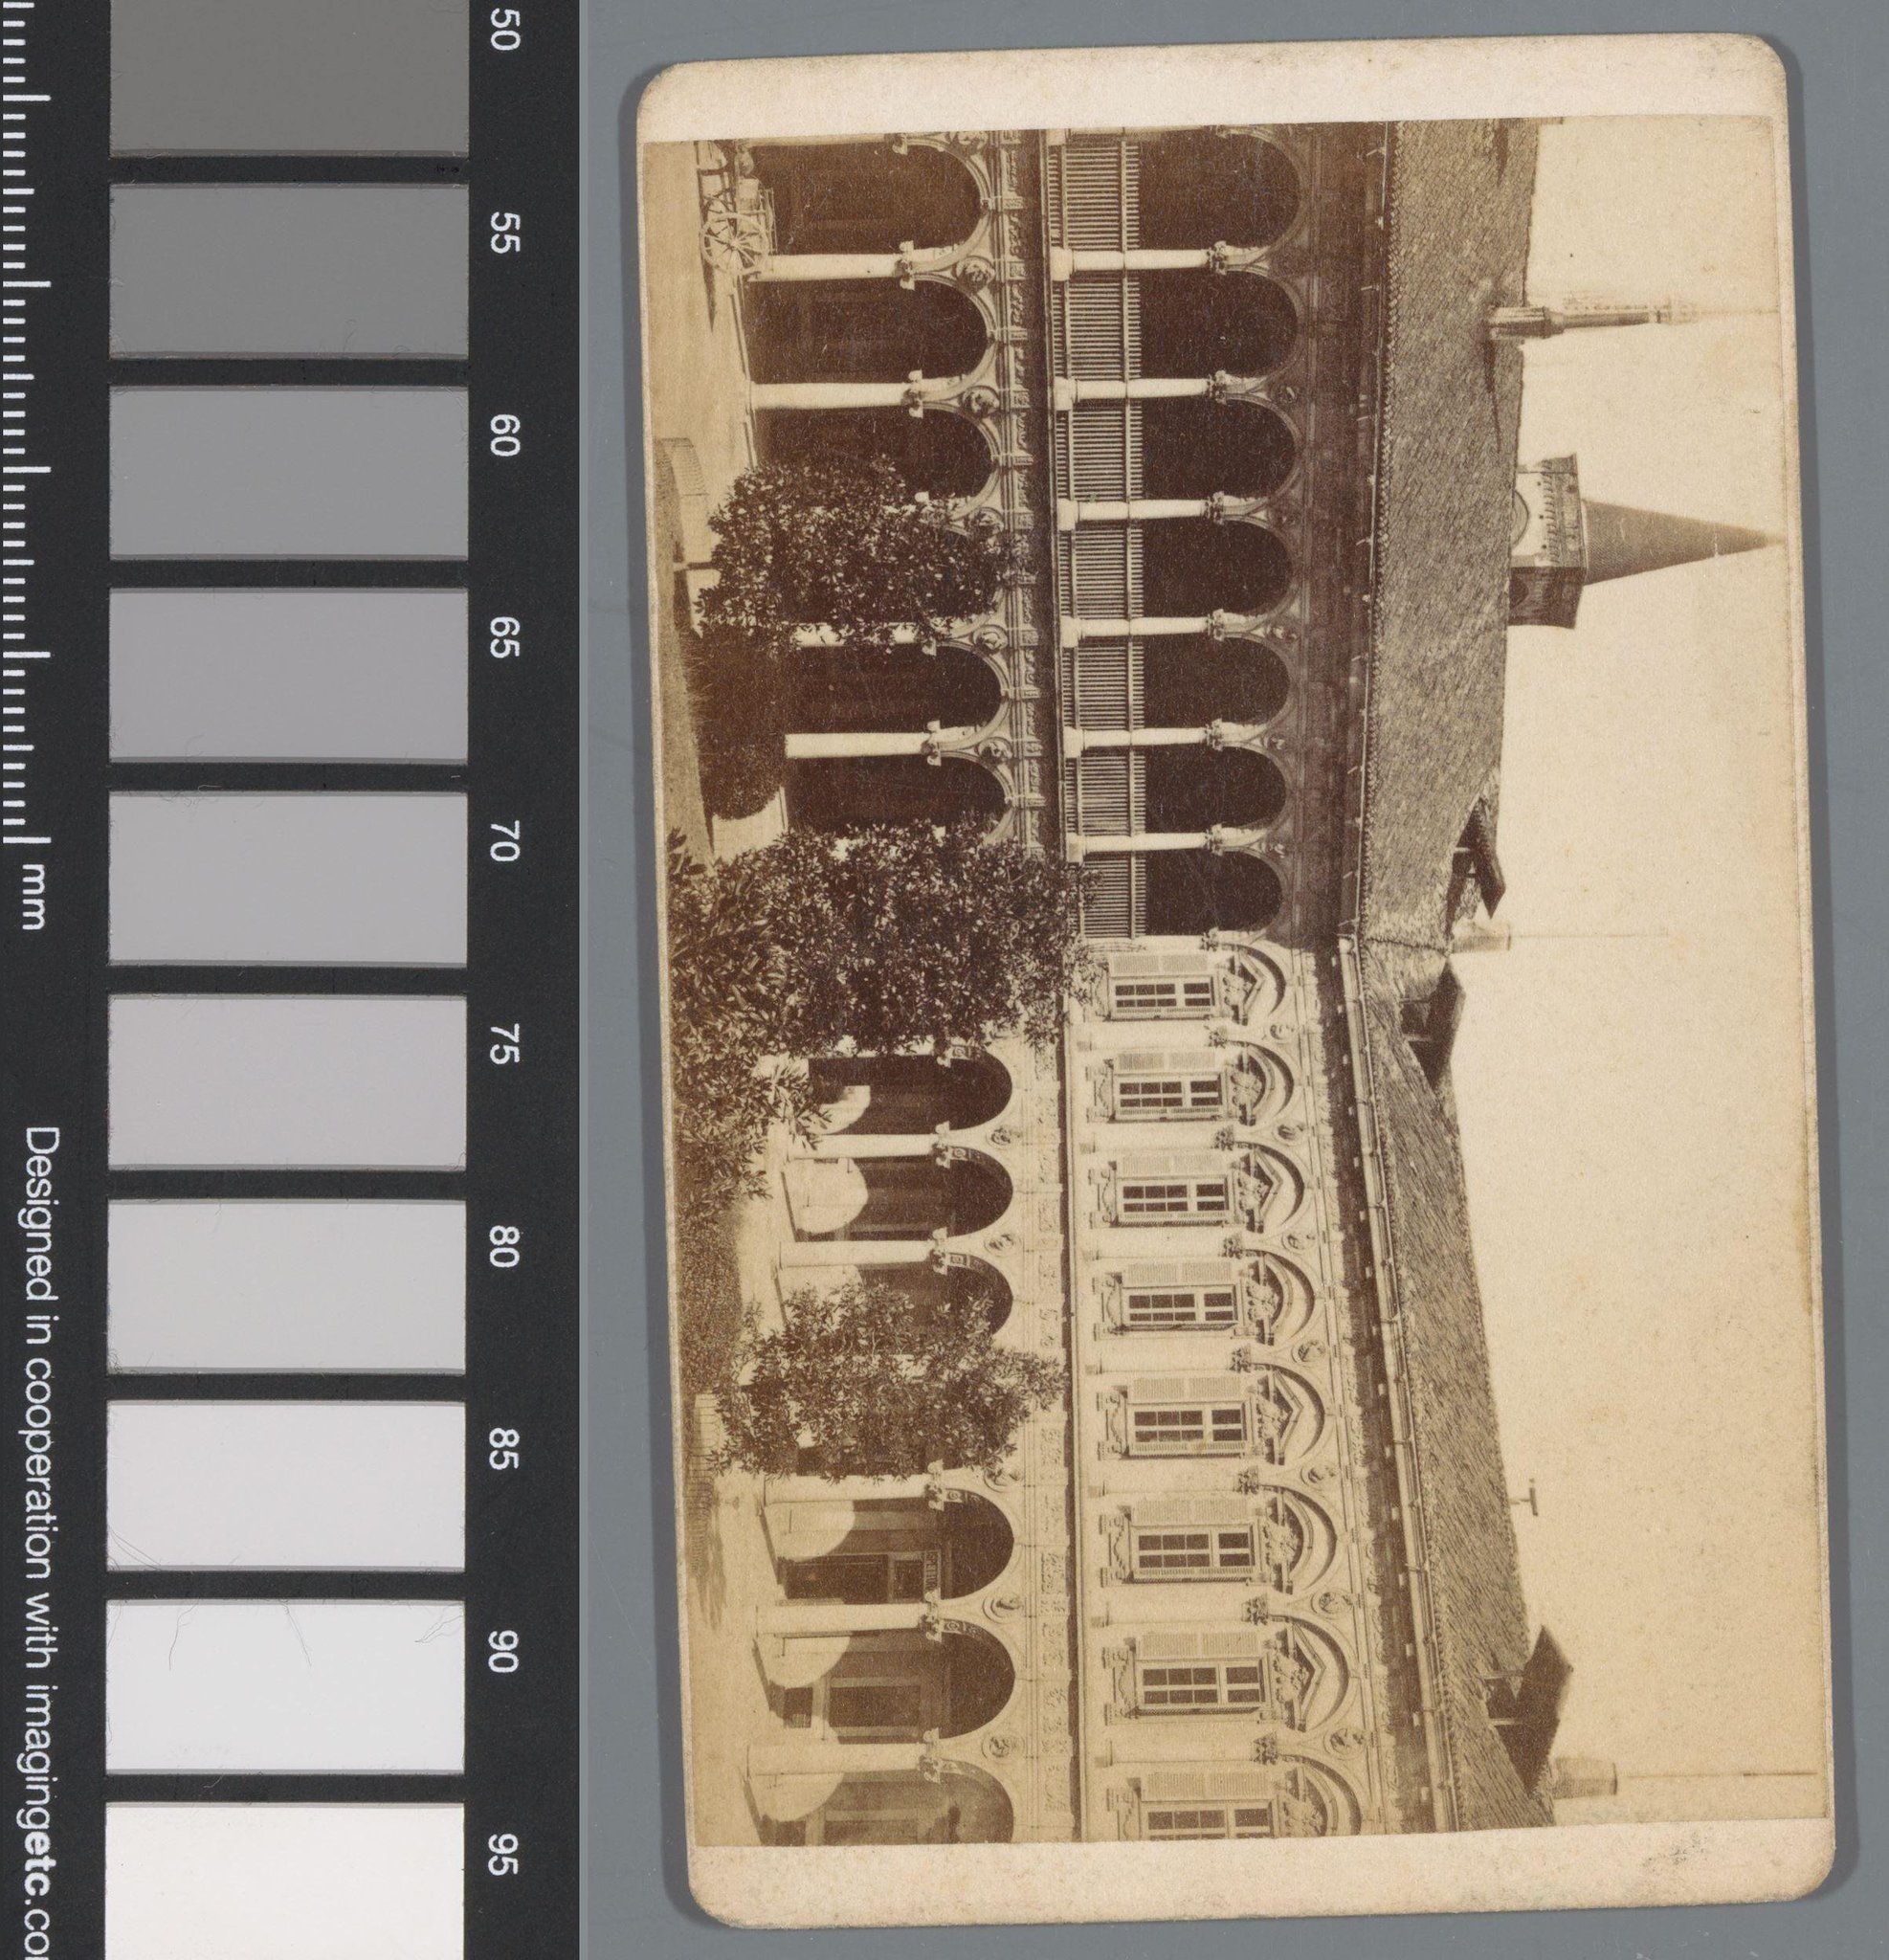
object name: photograph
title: Binnenplaats van het Antico Ospedale Maggiore, Milaan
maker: Anonymous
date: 1855-1885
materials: cardboard, paper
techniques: albumen print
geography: milan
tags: façade of inner court, arcade ~ architecture